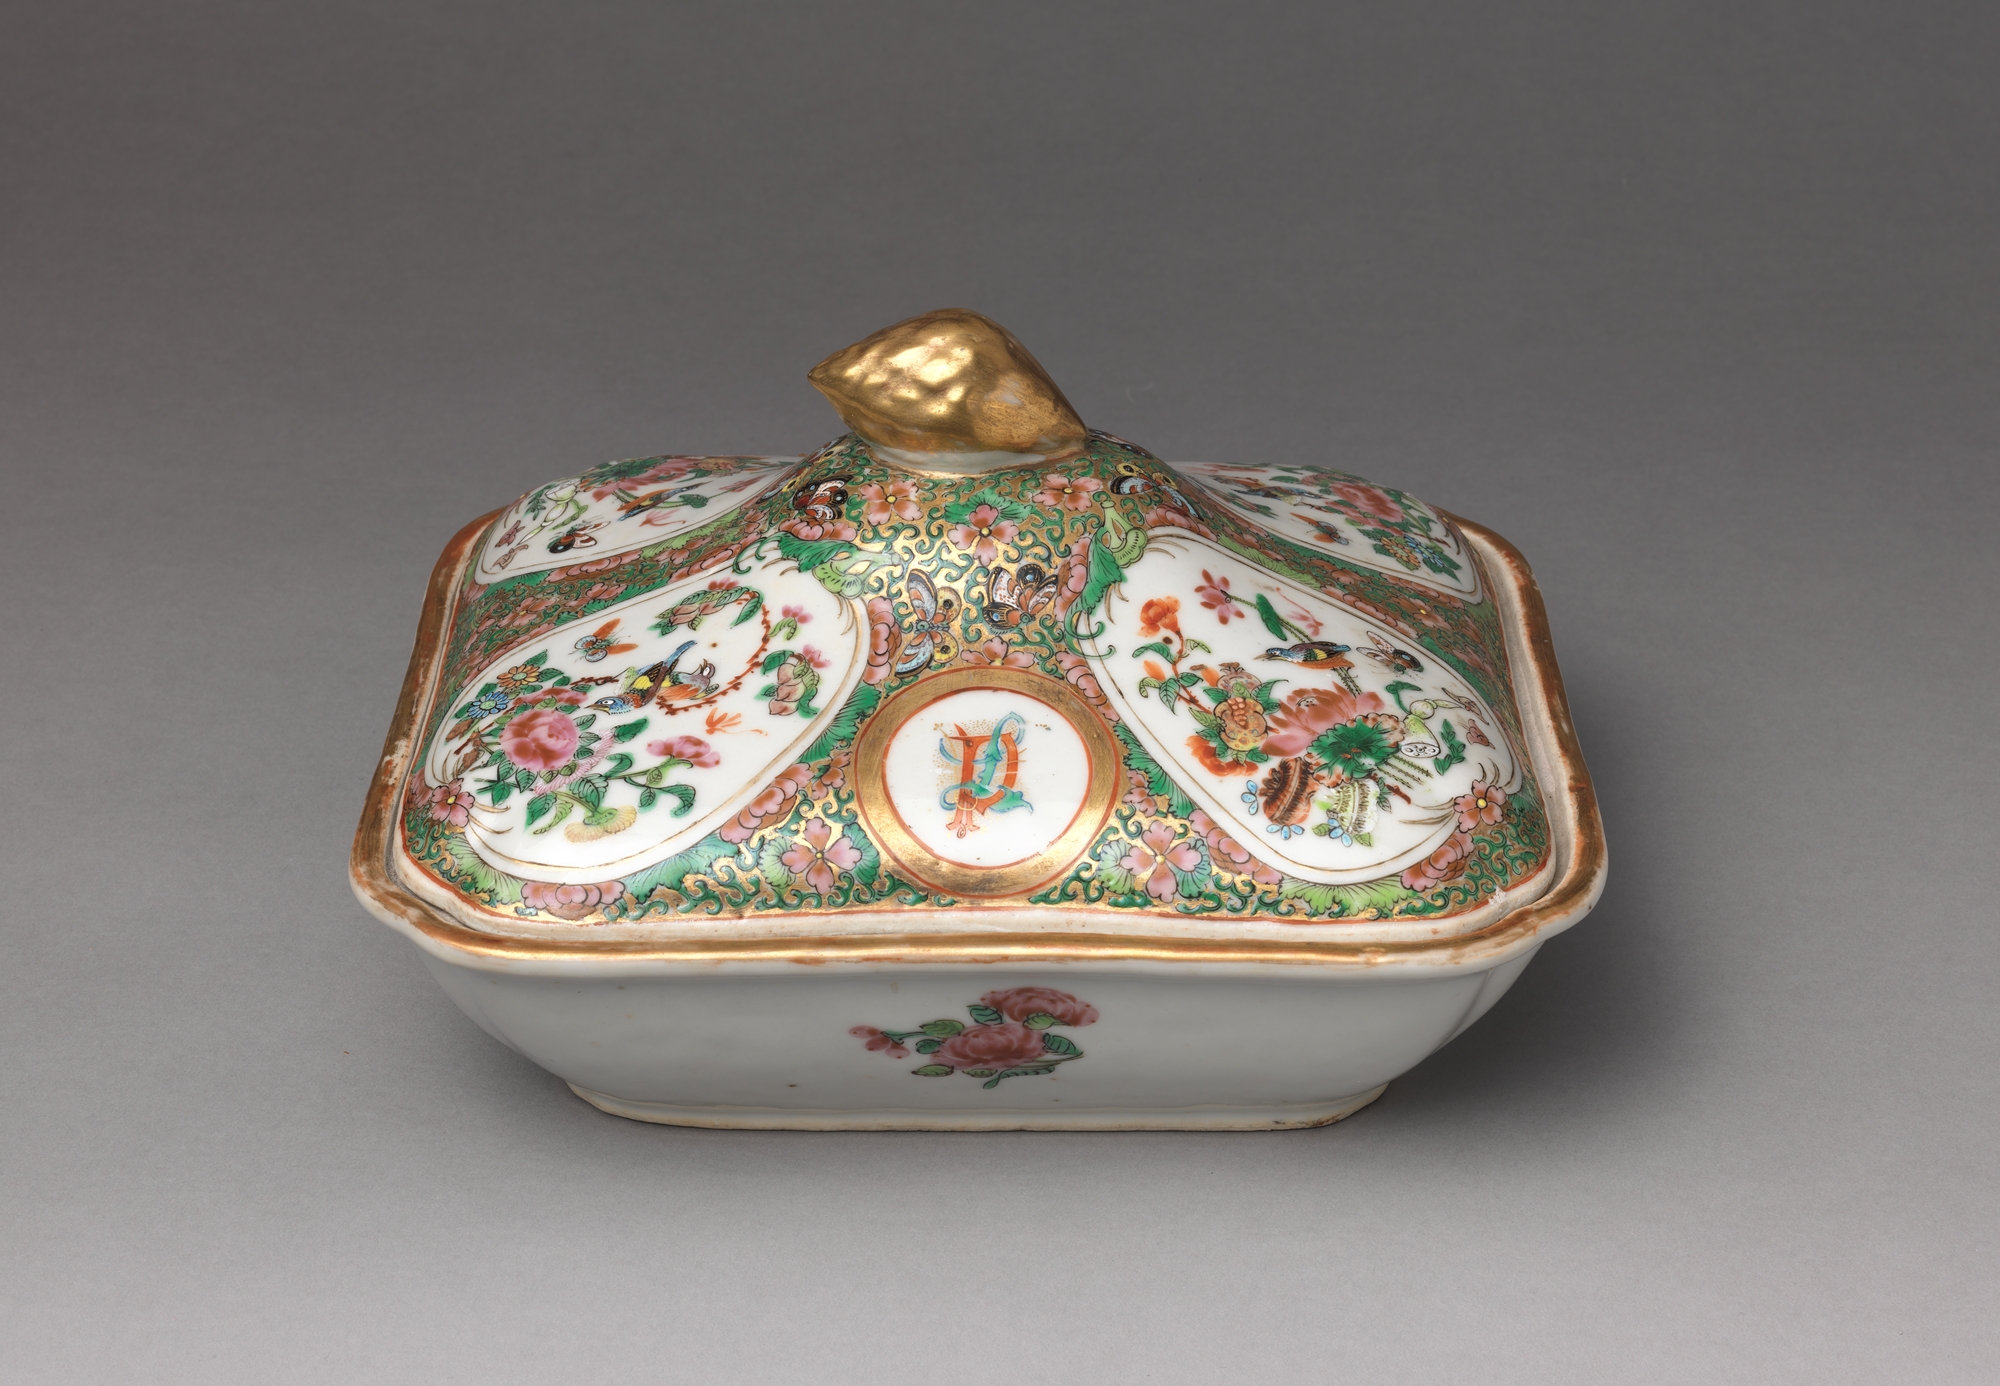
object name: serving dish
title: Covered Serving Dish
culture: chinese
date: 1860-1866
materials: porcelain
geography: china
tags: birds,butterflies,flowers